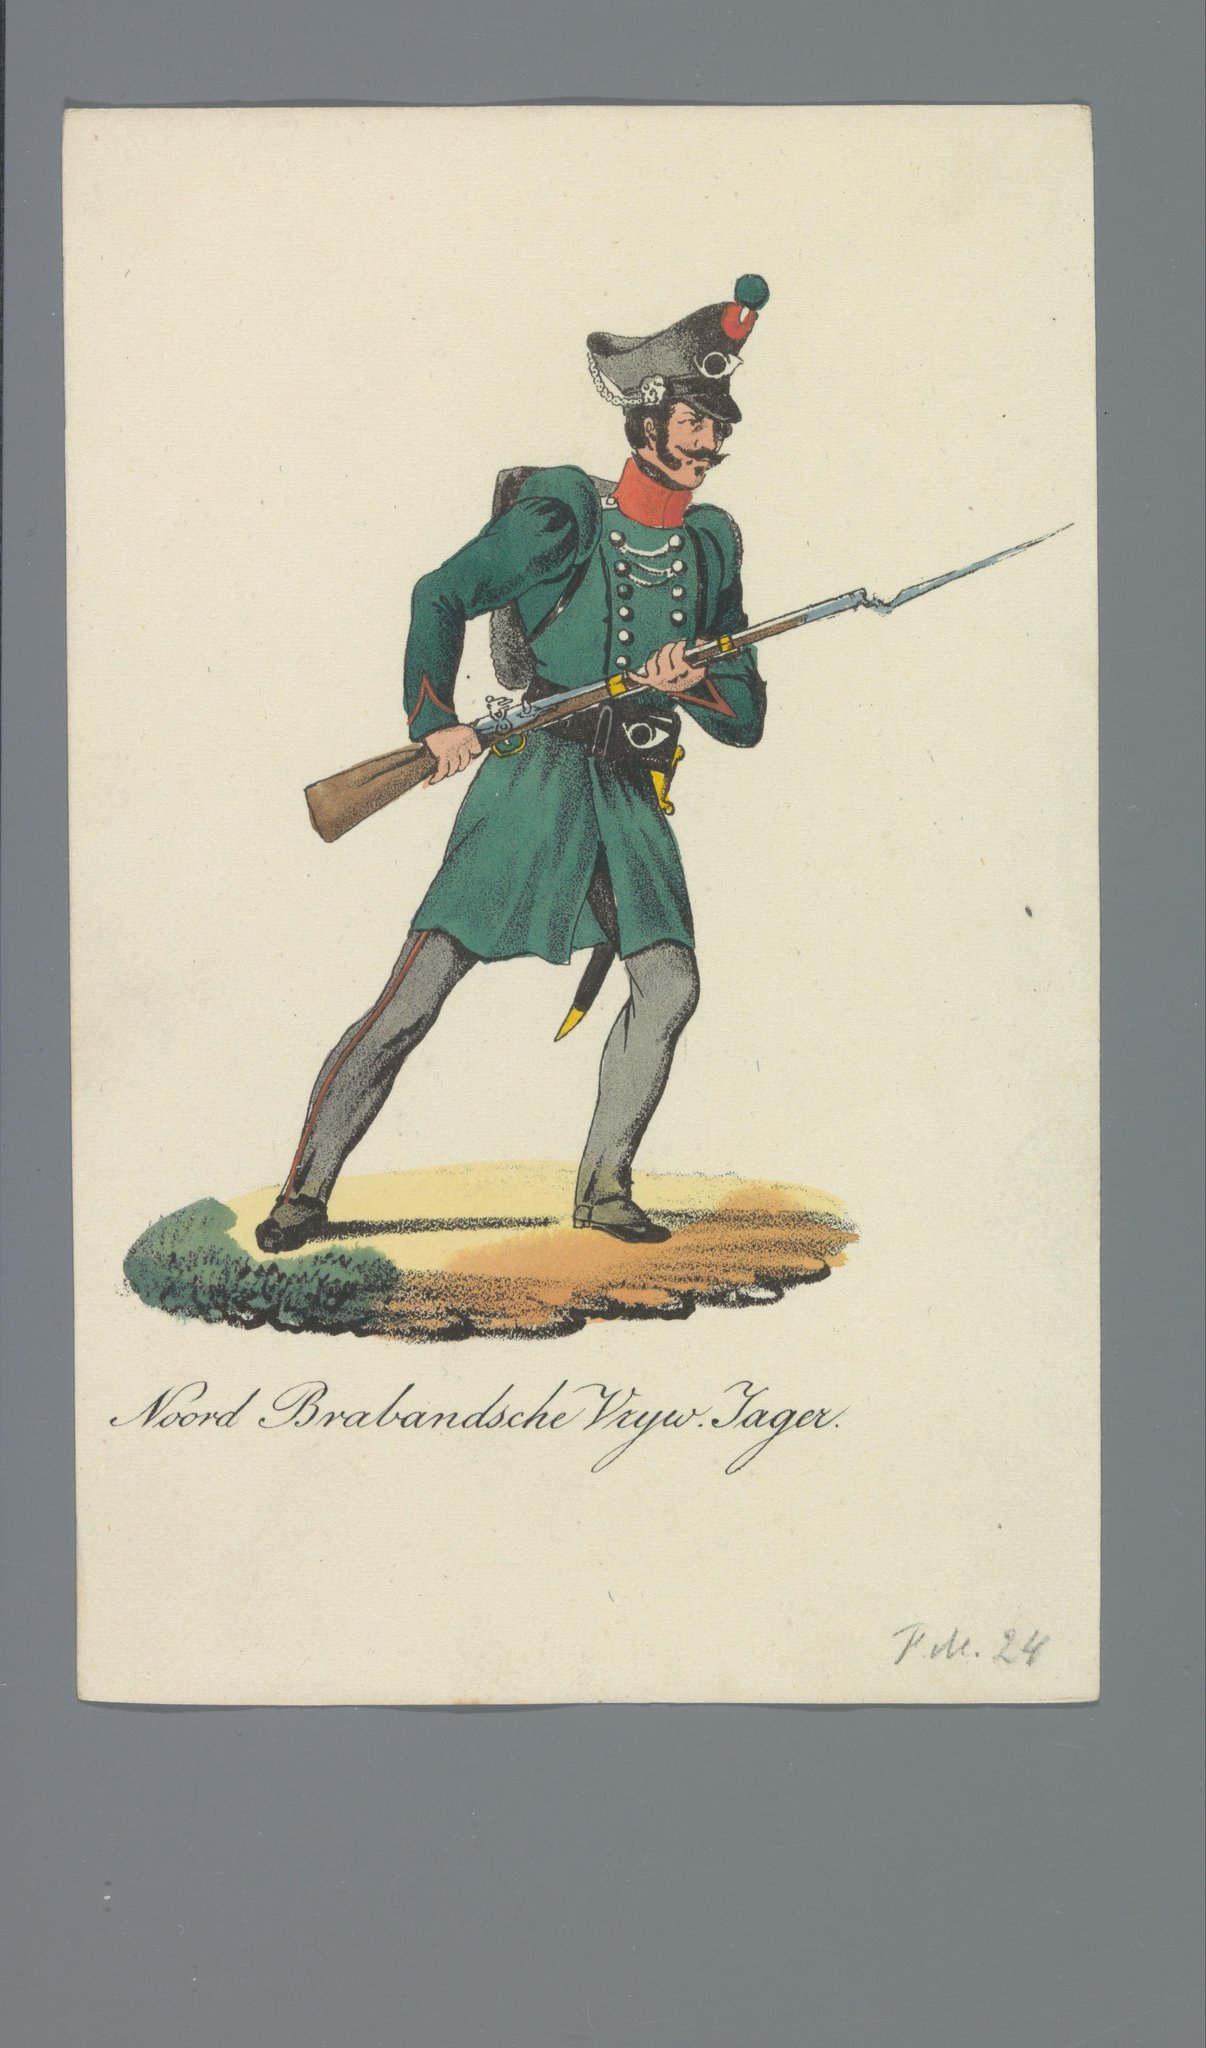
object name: costume print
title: Nederlandse militaire uniformen in de jaren 1830-1832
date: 1835-1850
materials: paper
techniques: hand coloring, lithograph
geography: utrecht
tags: (military) uniforms, clothes, costume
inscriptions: collector's mark: Lugt 2228, collector's mark: Lugt 2227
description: Staande jager van het Korps Noord-Brabantse Jagers. Onderdeel van een serie van 157 losse bladen met Nederlandse militaire uniformen in de jaren 1830-1832.